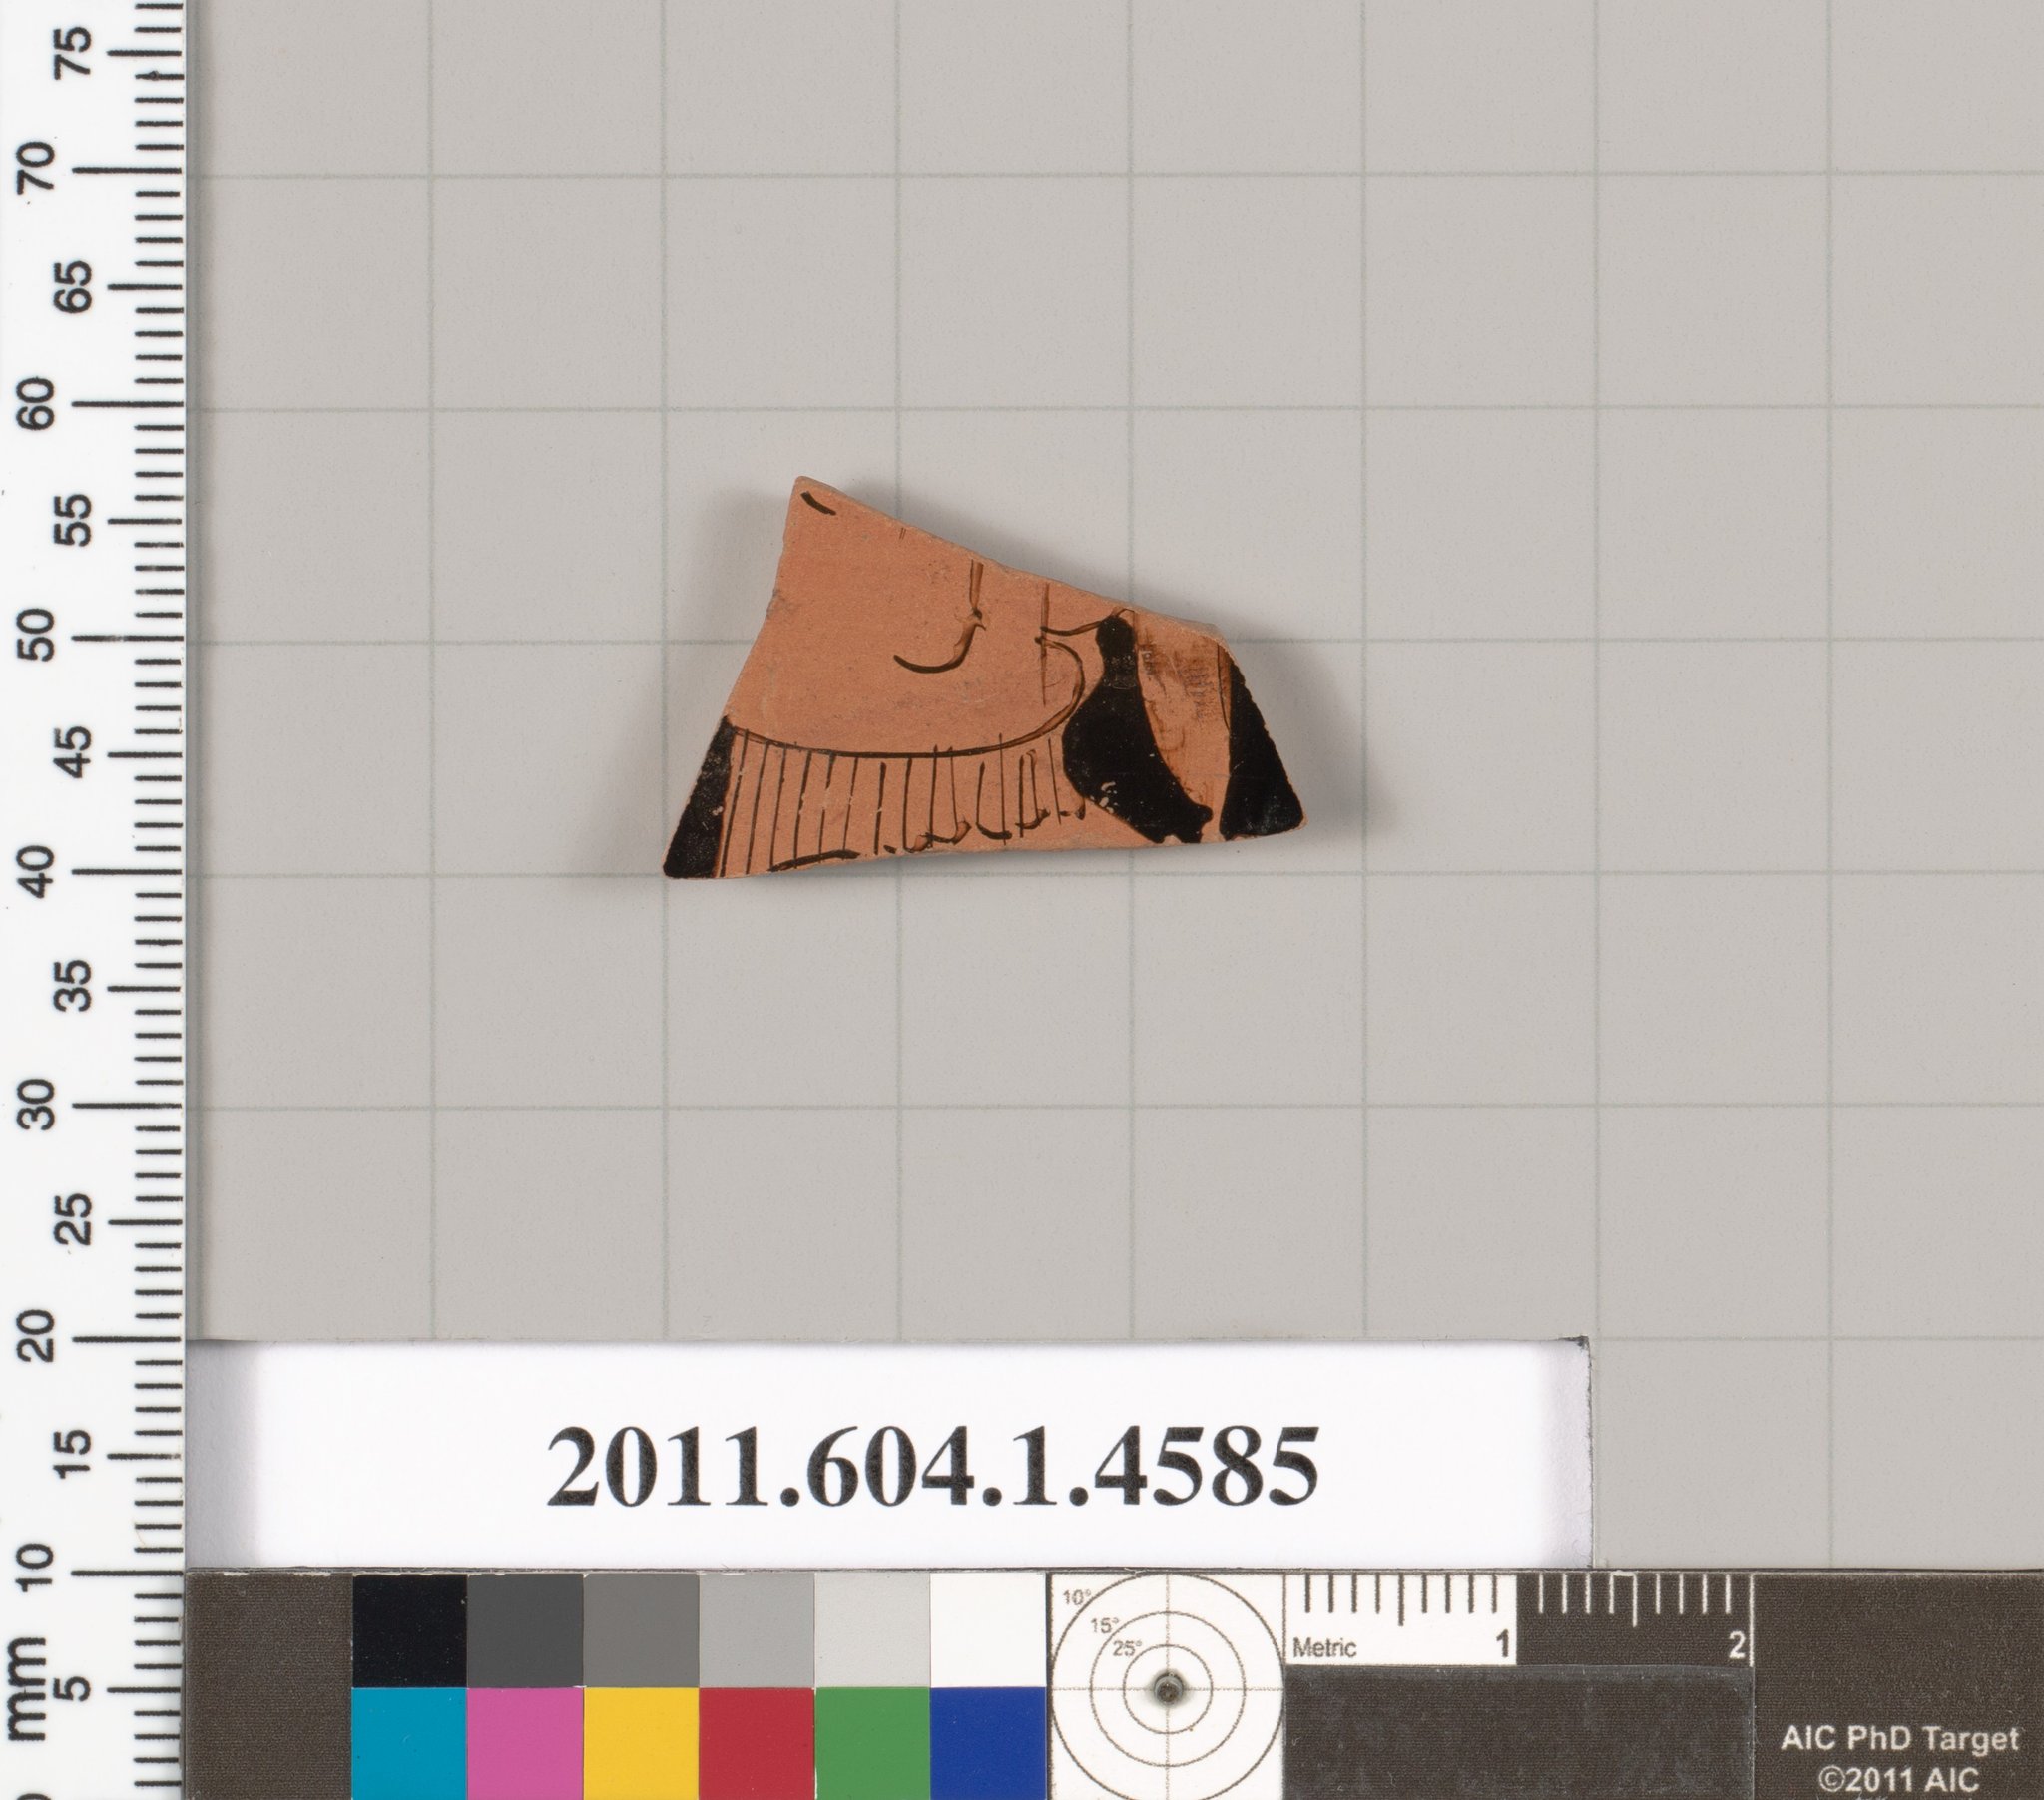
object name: kylix fragment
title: Terracotta fragment of a kylix (drinking cup)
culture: greek, attic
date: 475-451 BCE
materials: terracotta